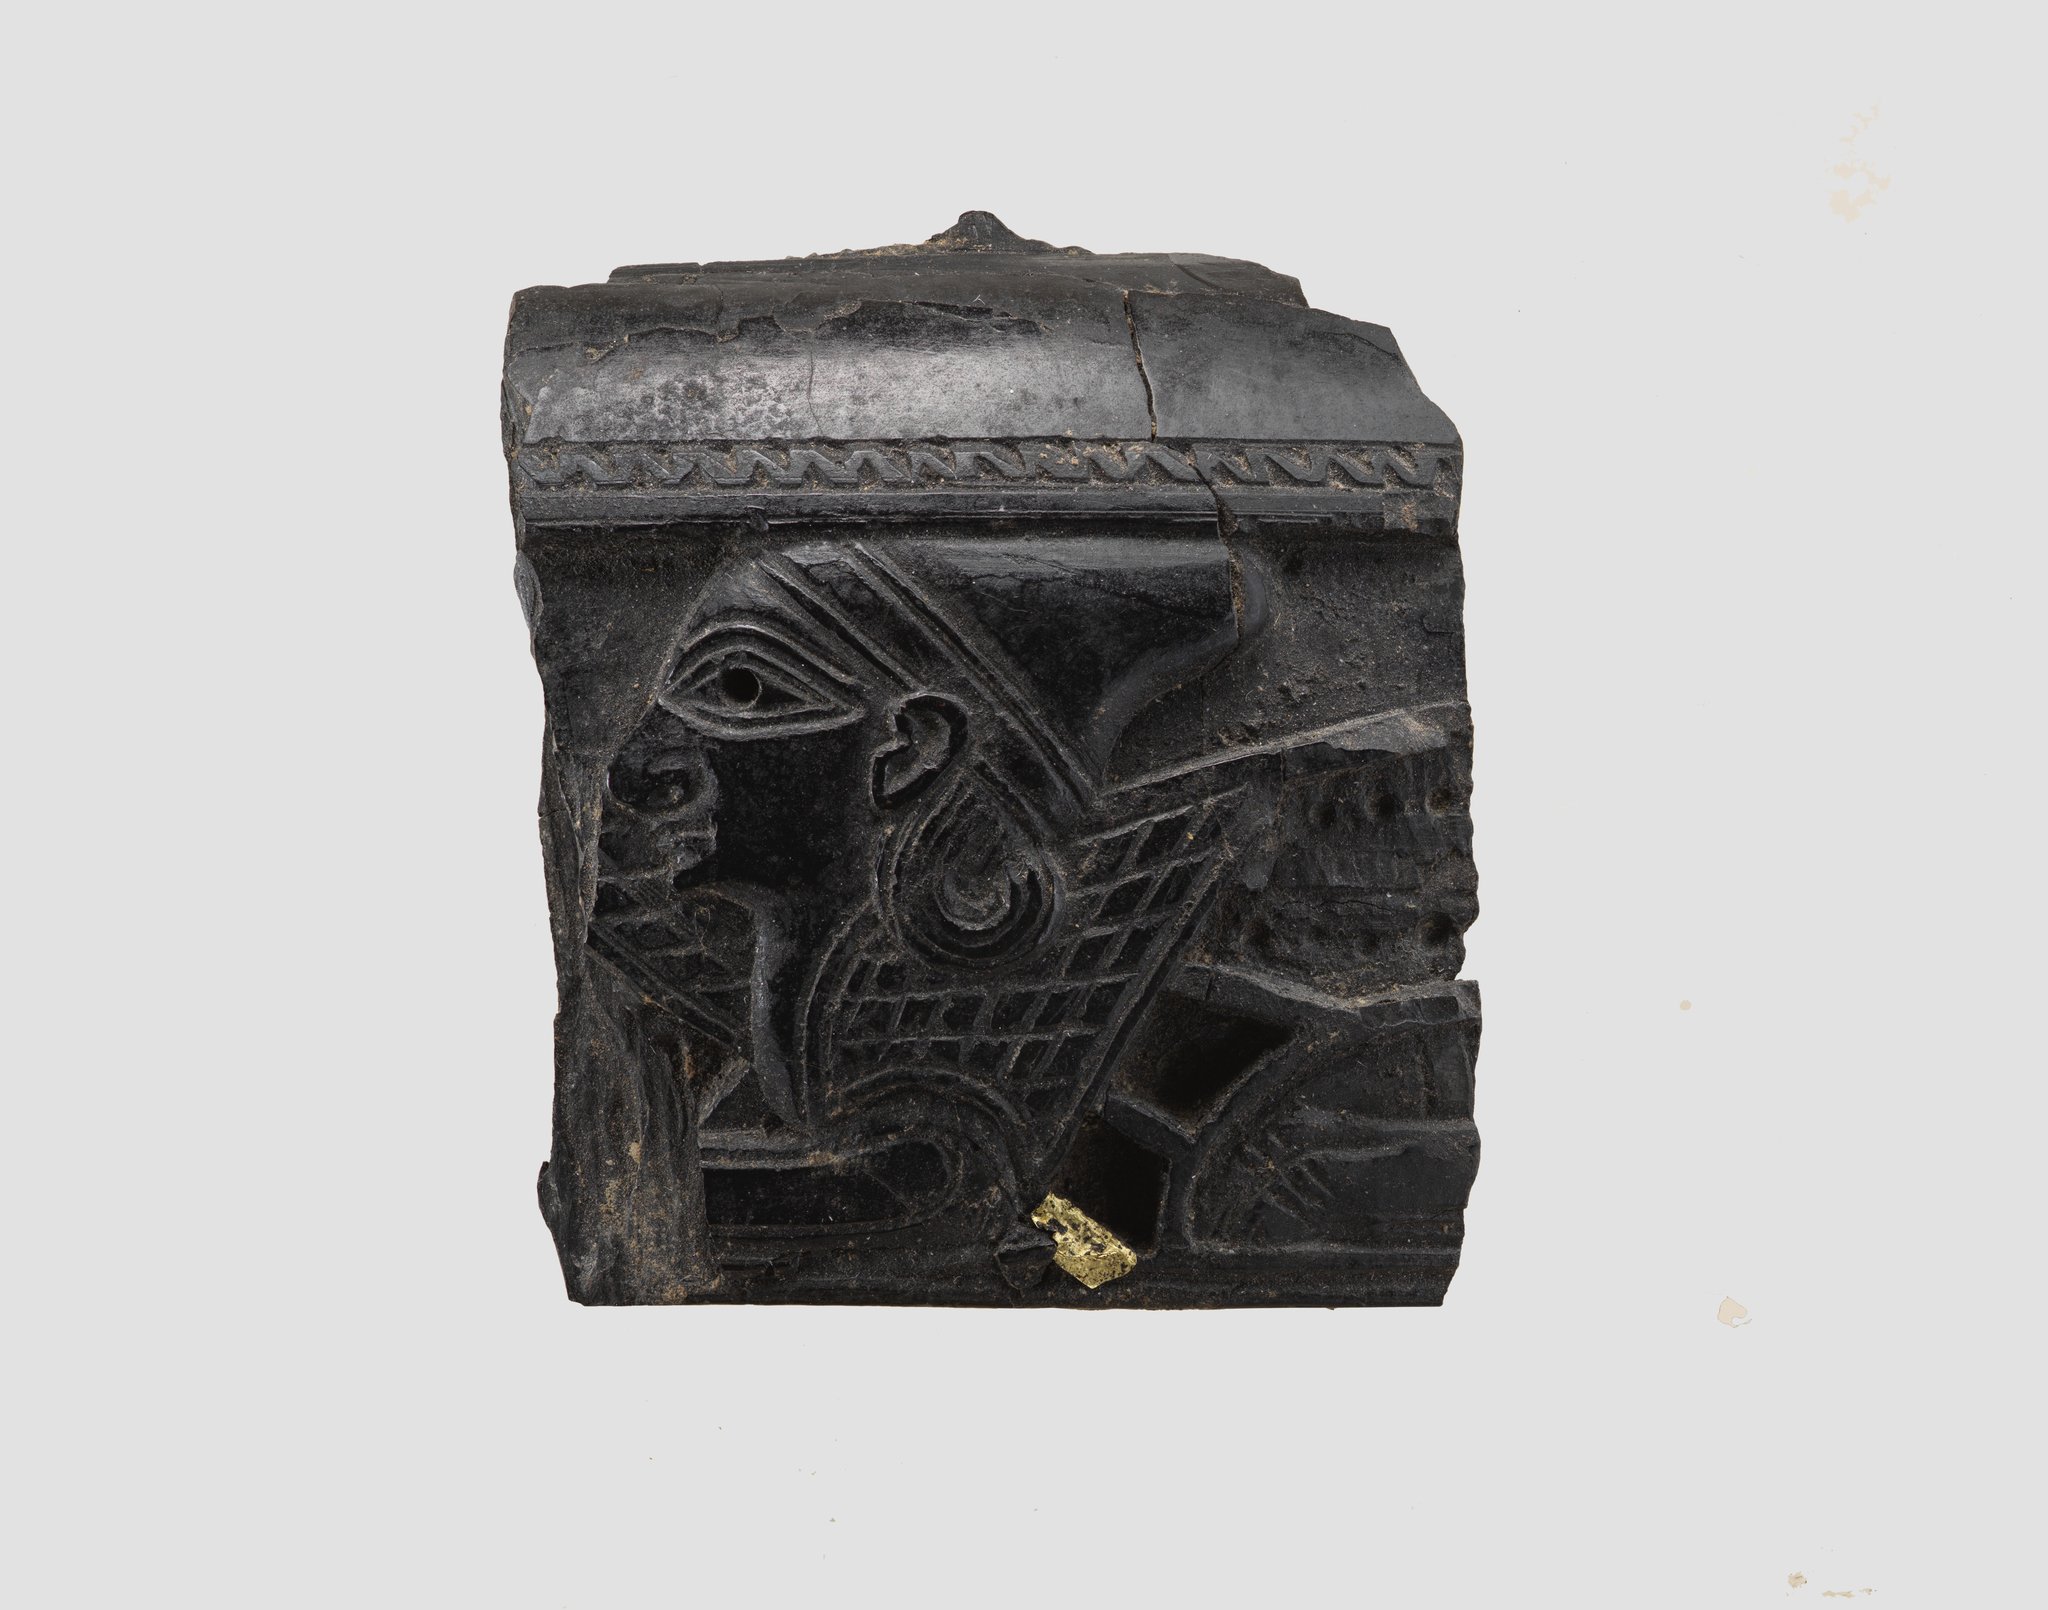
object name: cosmetic container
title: Cosmetic box fragment carved in relief with the head of a sphinx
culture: iranian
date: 900-801 BCE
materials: gold foil, ivory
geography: iran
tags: sphinx